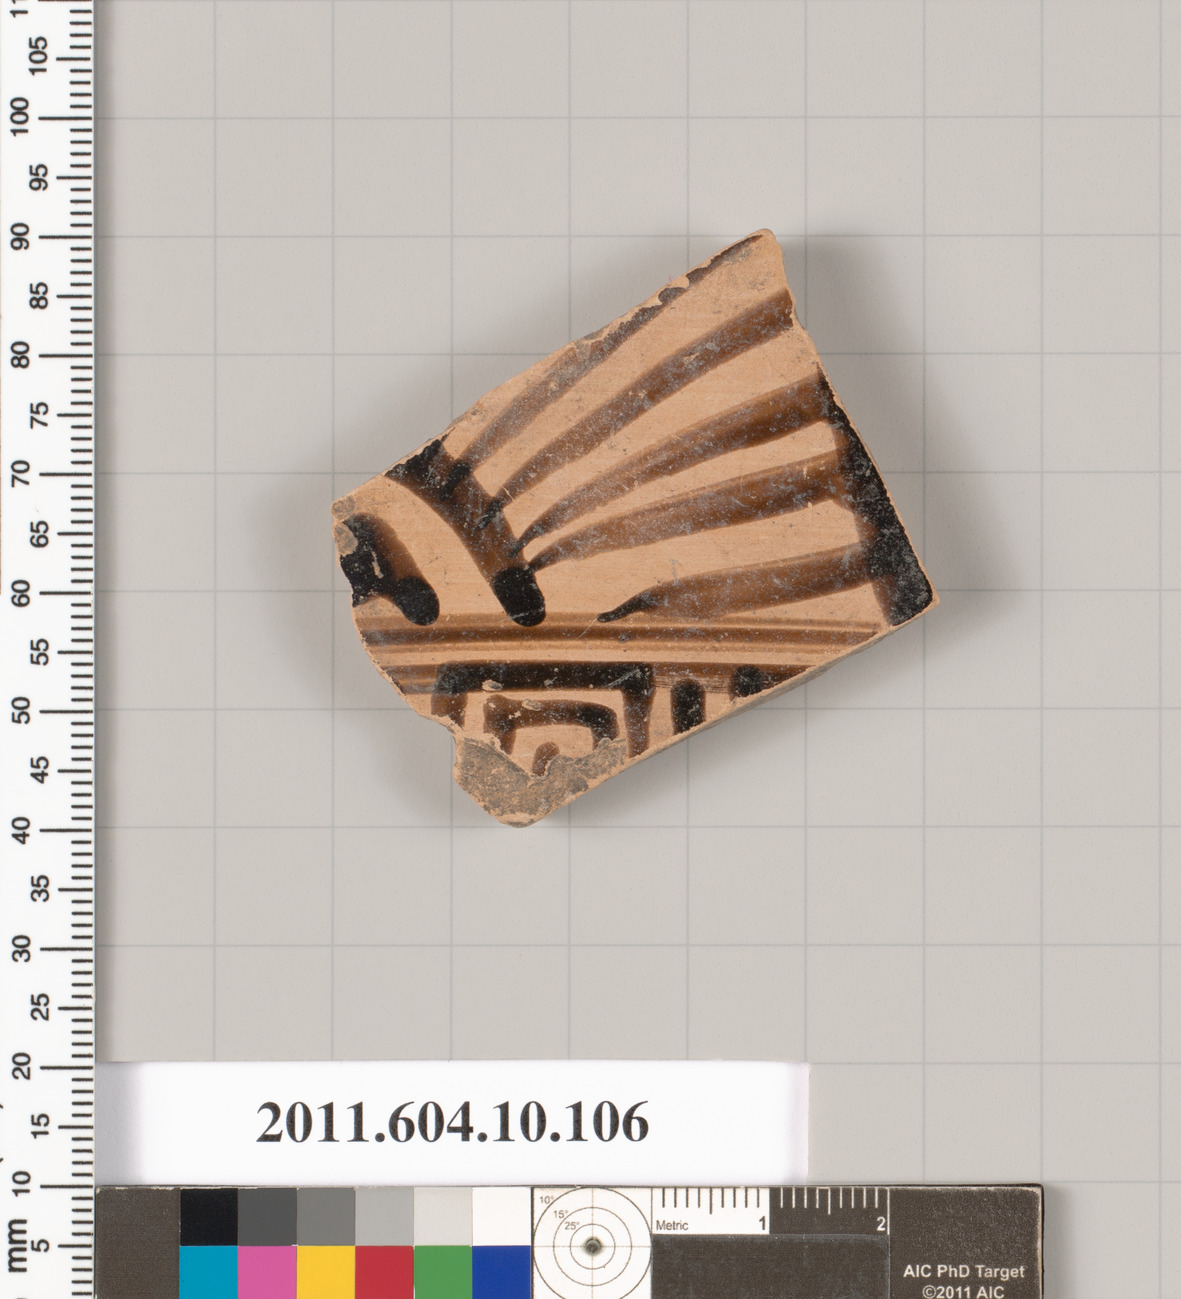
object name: krater fragment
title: Terracotta fragment of a krater (deep bowl)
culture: etruscan or faliscan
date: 400-301 BCE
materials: terracotta